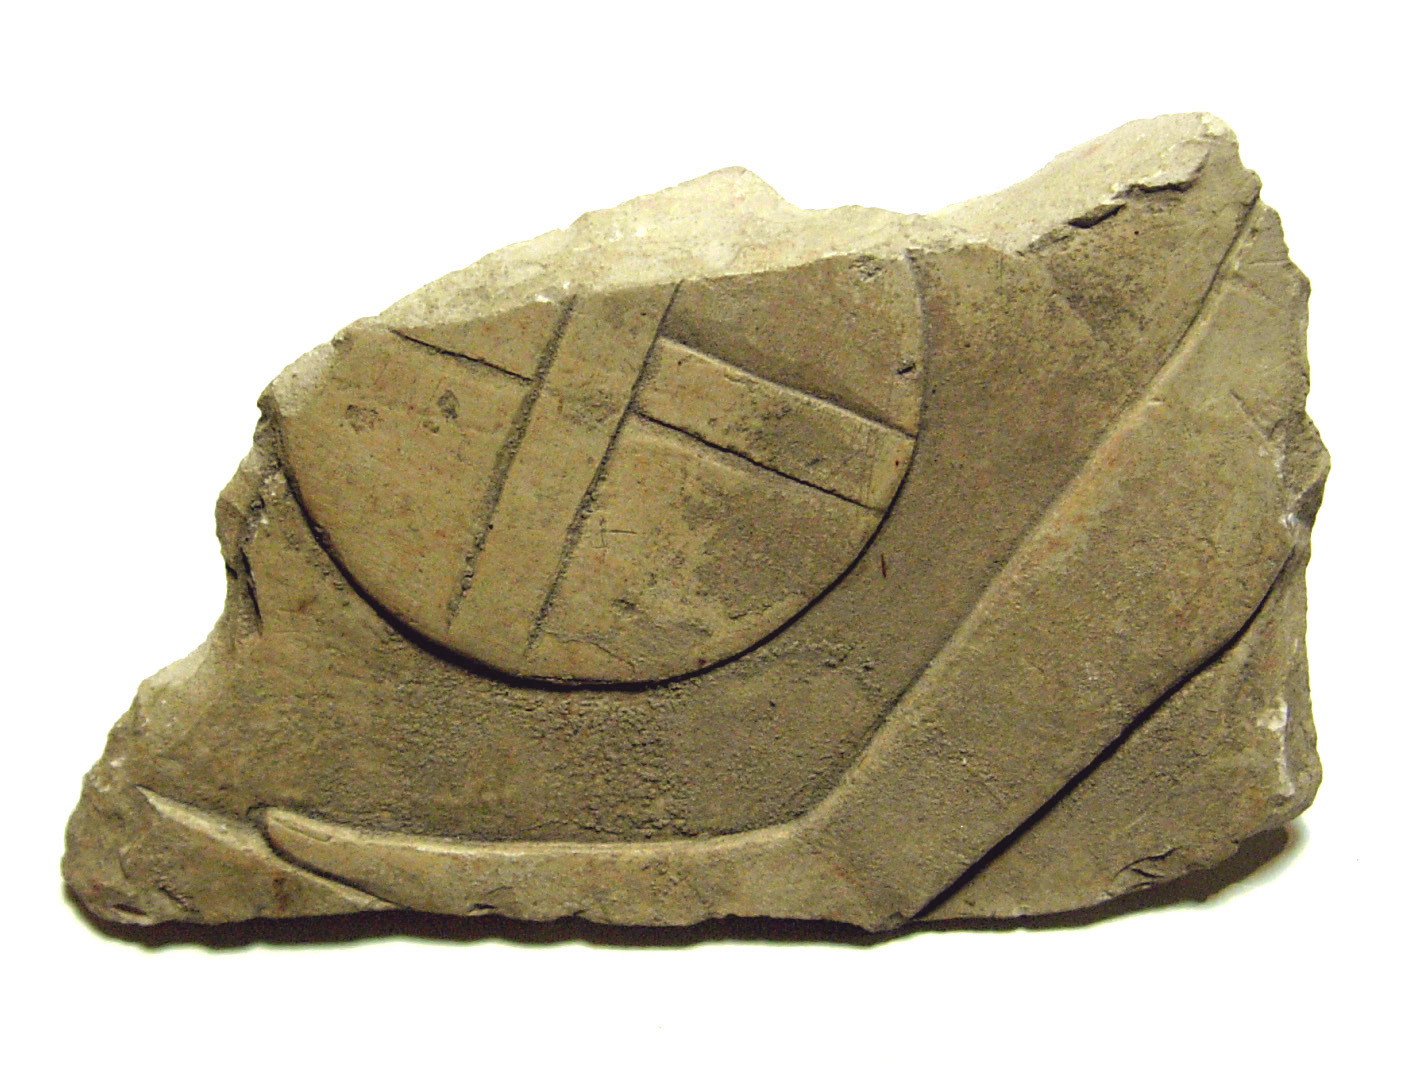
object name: relief, tomb of nespekashuty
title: Raised relief fragment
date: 664-610 BCE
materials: limestone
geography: egypt